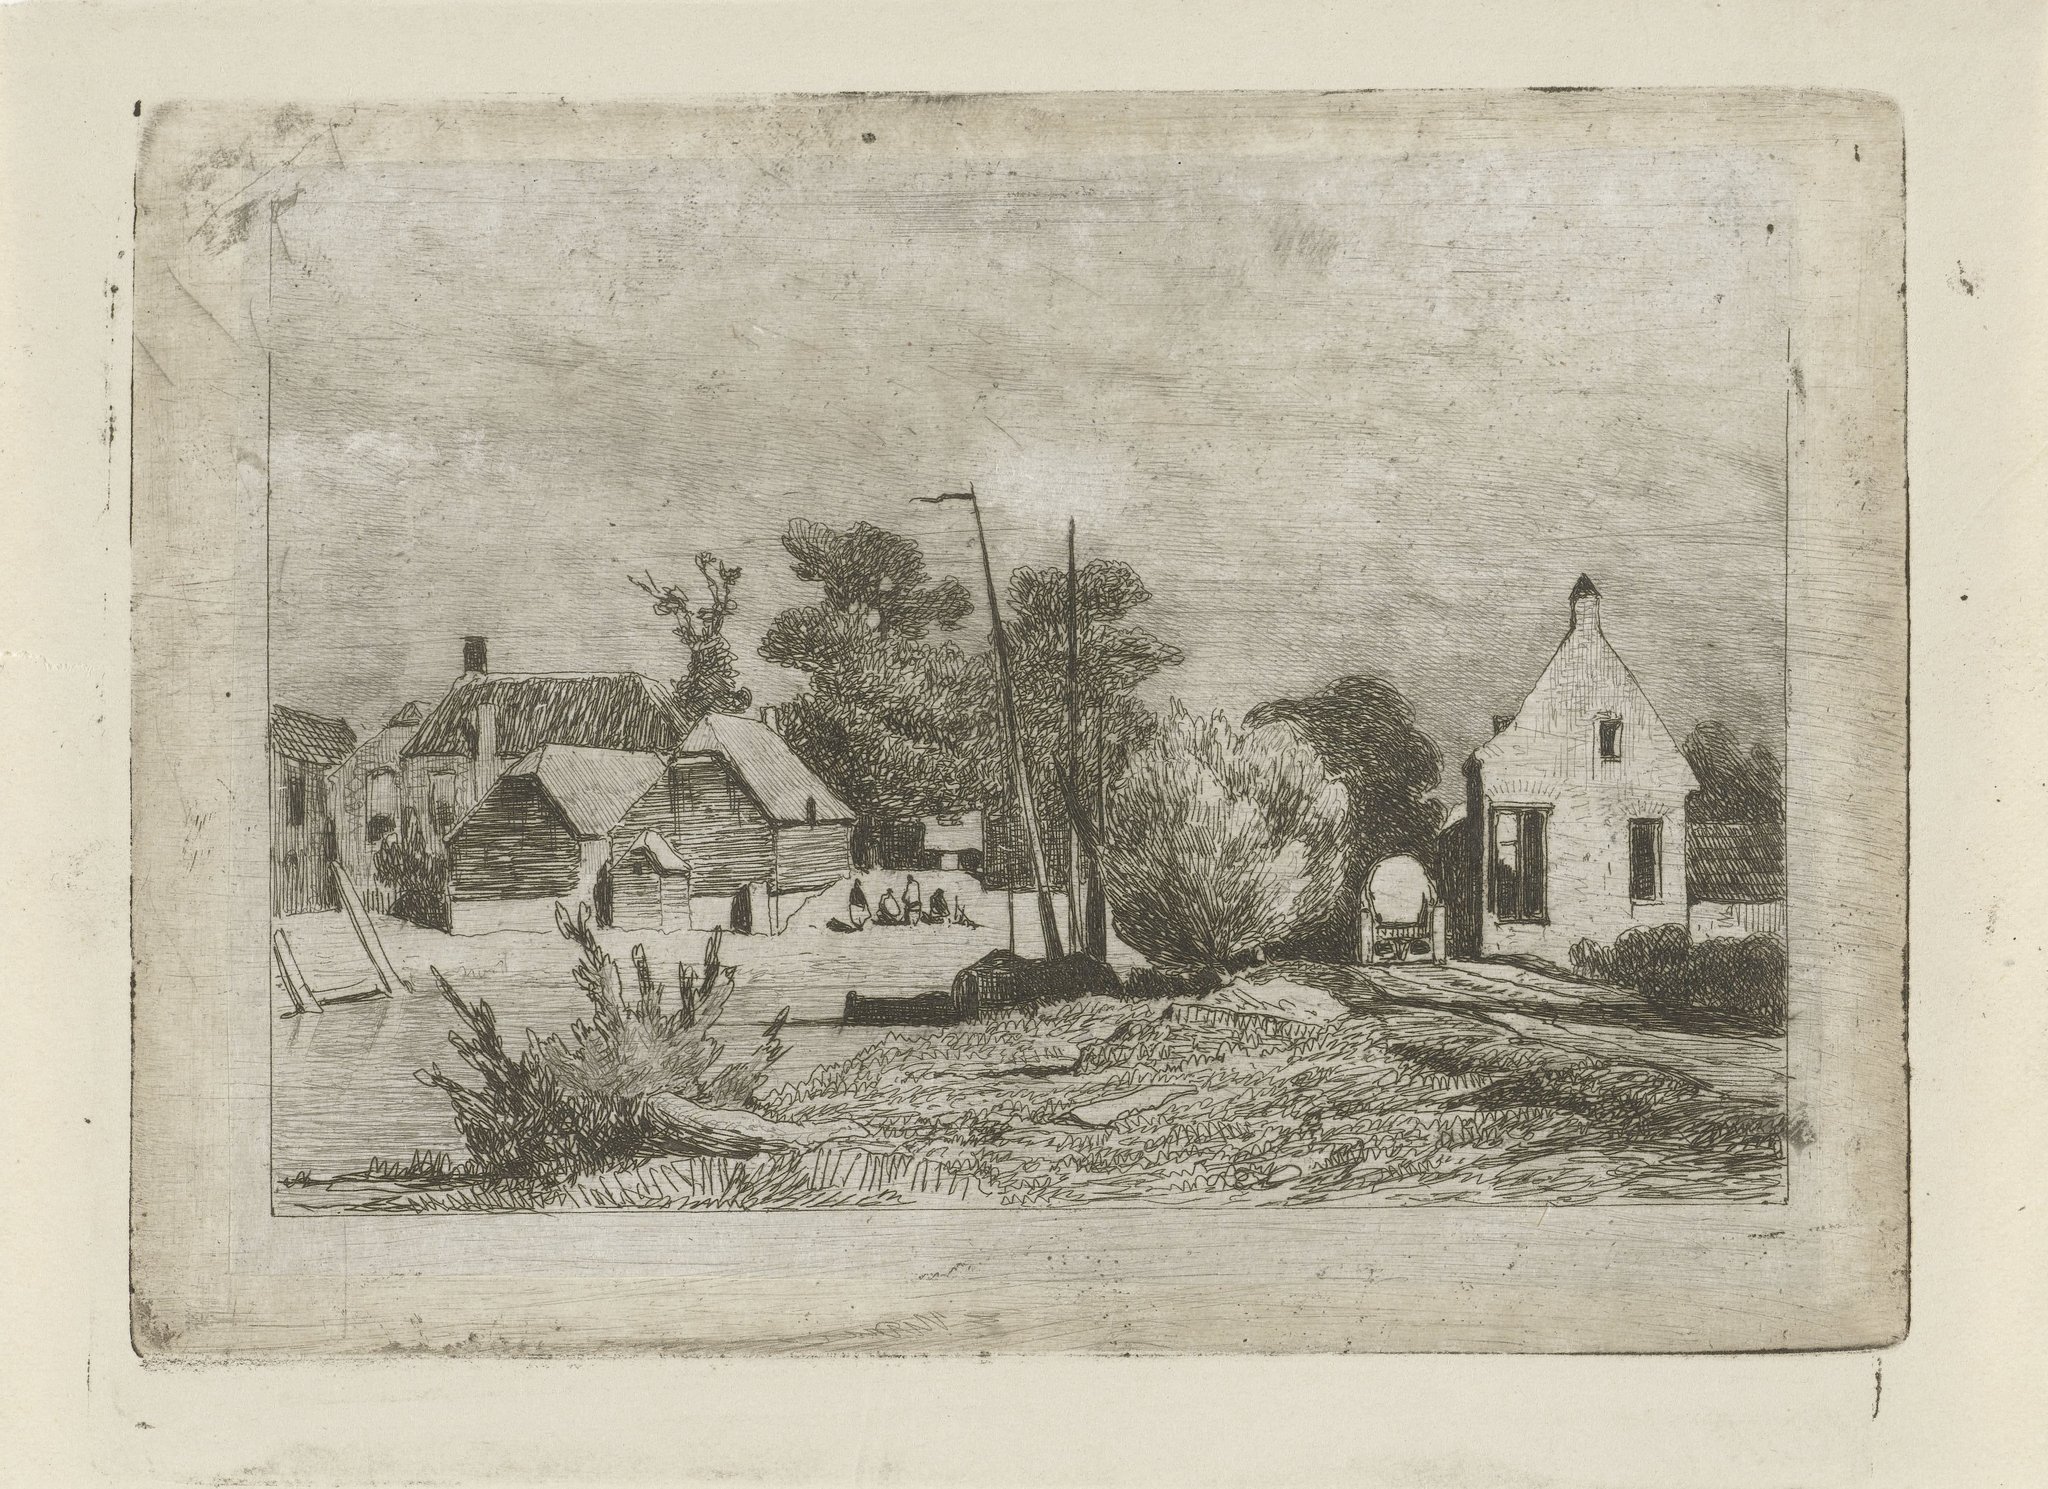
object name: print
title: Gezicht op huizen en een boot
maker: lambertus hardenberg (1822-1900)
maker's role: draughtsman, painter, print maker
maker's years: 1822-1900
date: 1837-1900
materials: paper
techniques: etching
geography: the hague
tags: parts of ship's exterior: mast, outskirts of village (+ city(-scape) with figures, staffage)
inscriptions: collector's mark: Lugt 2228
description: Gezicht op enkele huizen met in het midden de uitstekende mast van een boot.